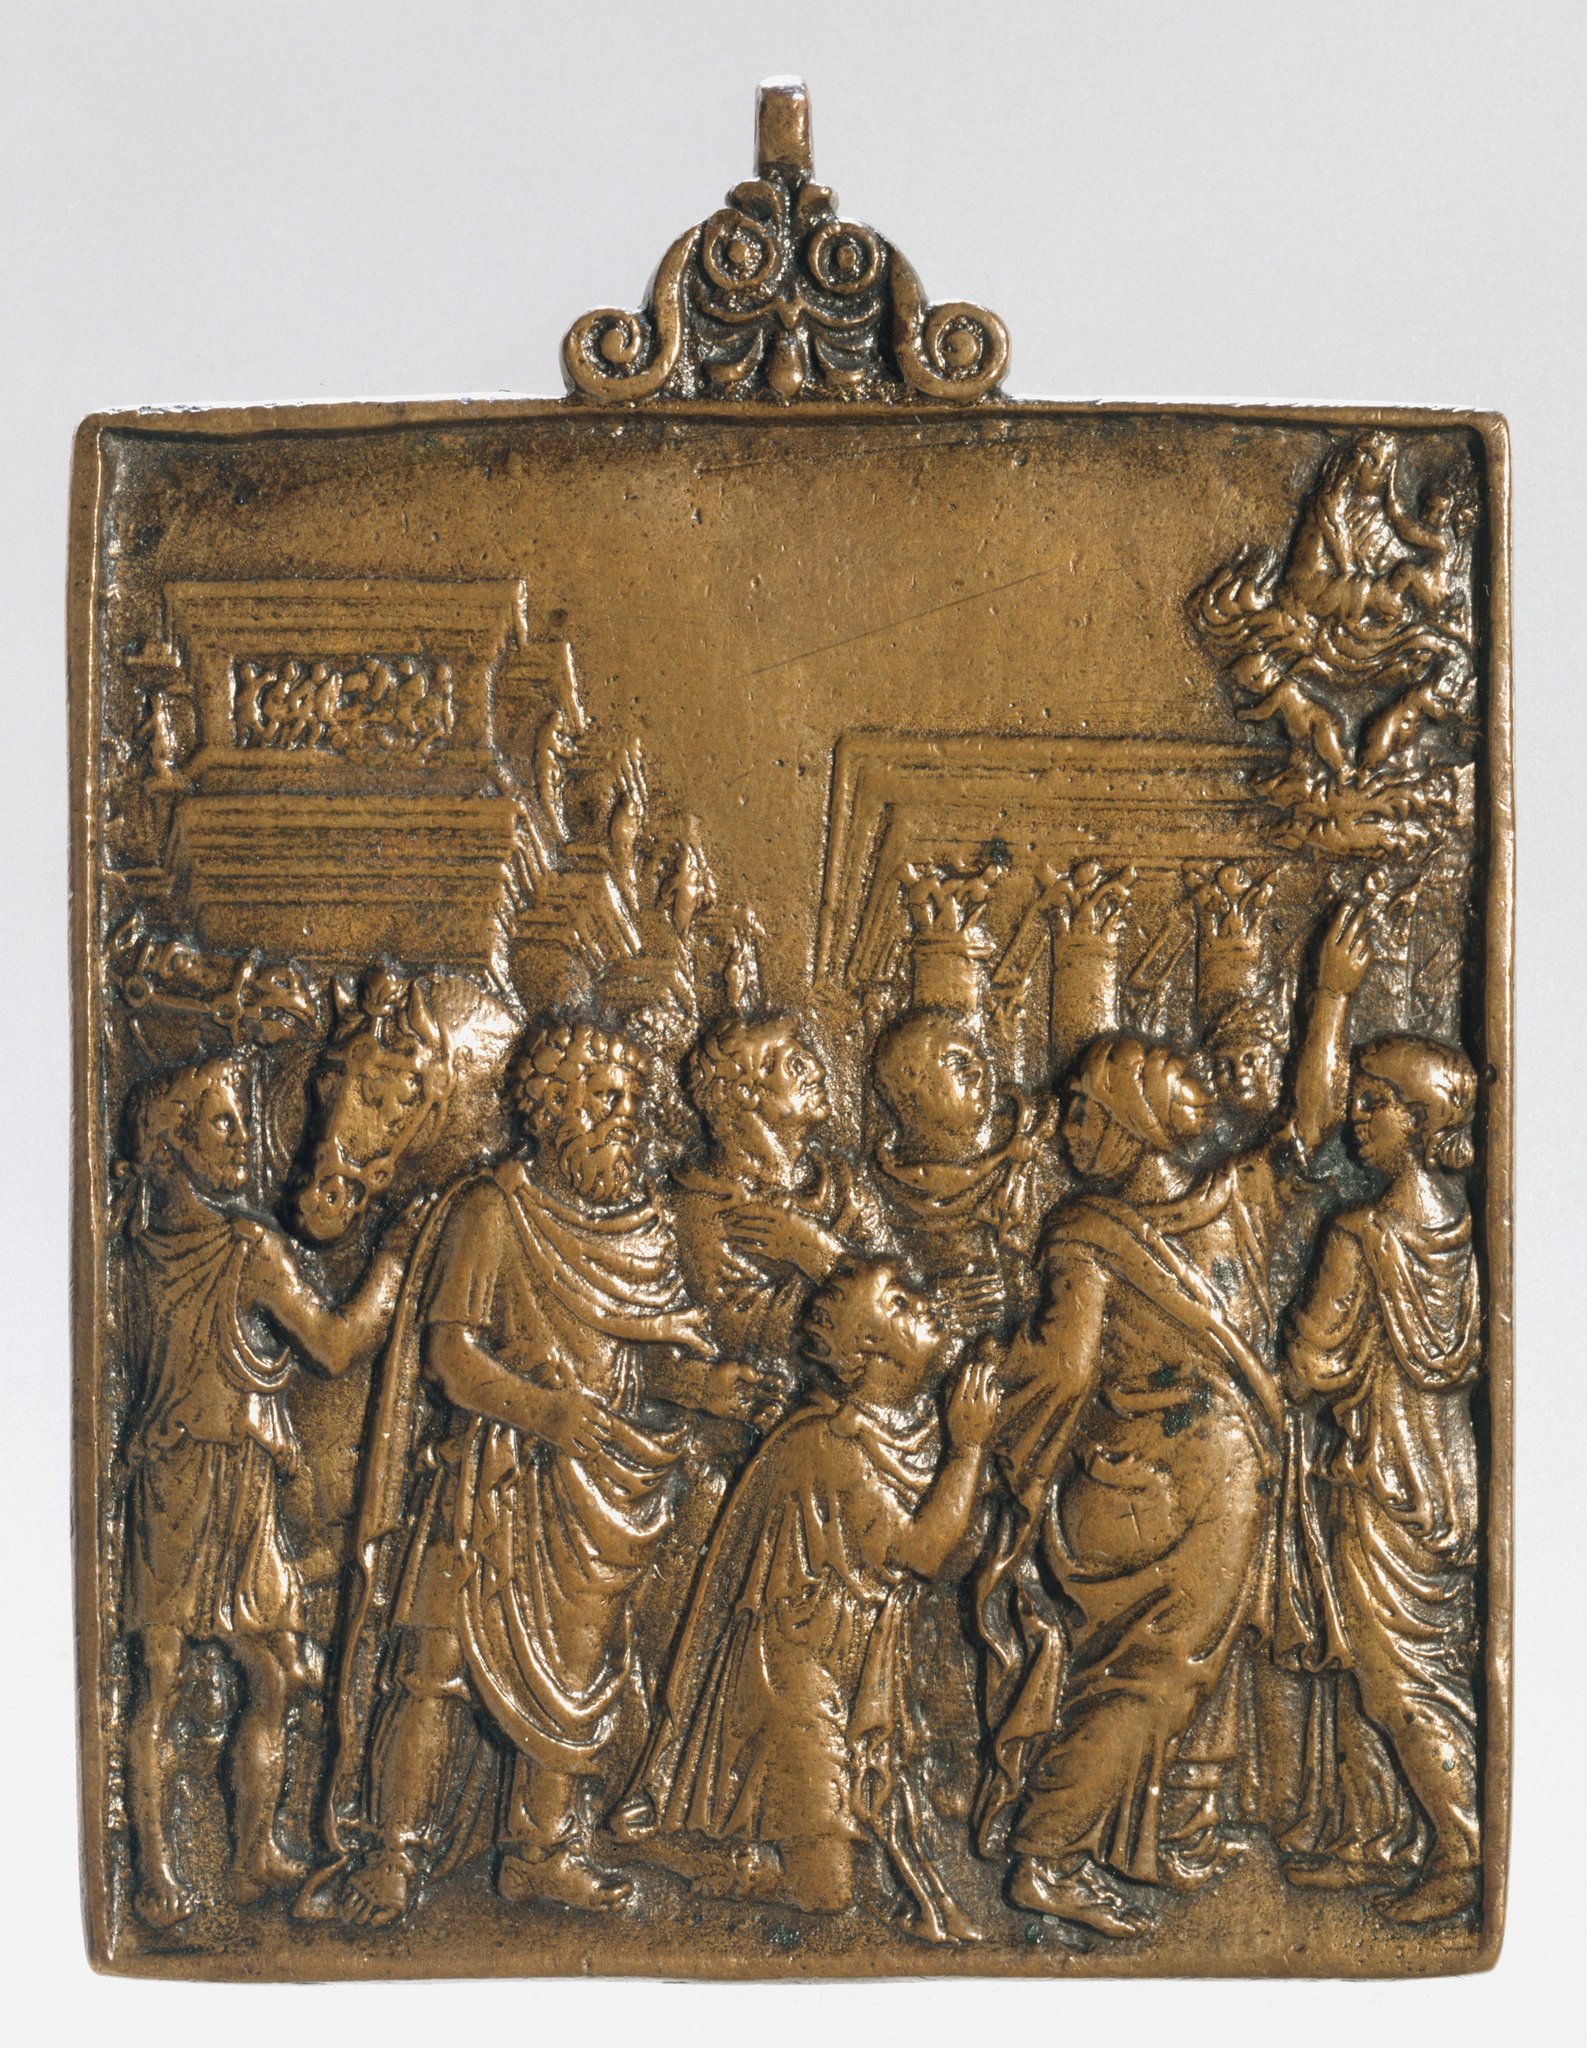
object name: plaquette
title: Augustus and the Tiburtine Sibyl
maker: caradosso (cristoforo caradosso foppa)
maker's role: maker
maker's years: 1470-1527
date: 1501-1600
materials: bronze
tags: emperor augustus,men,sibyl,horses,madonna and child